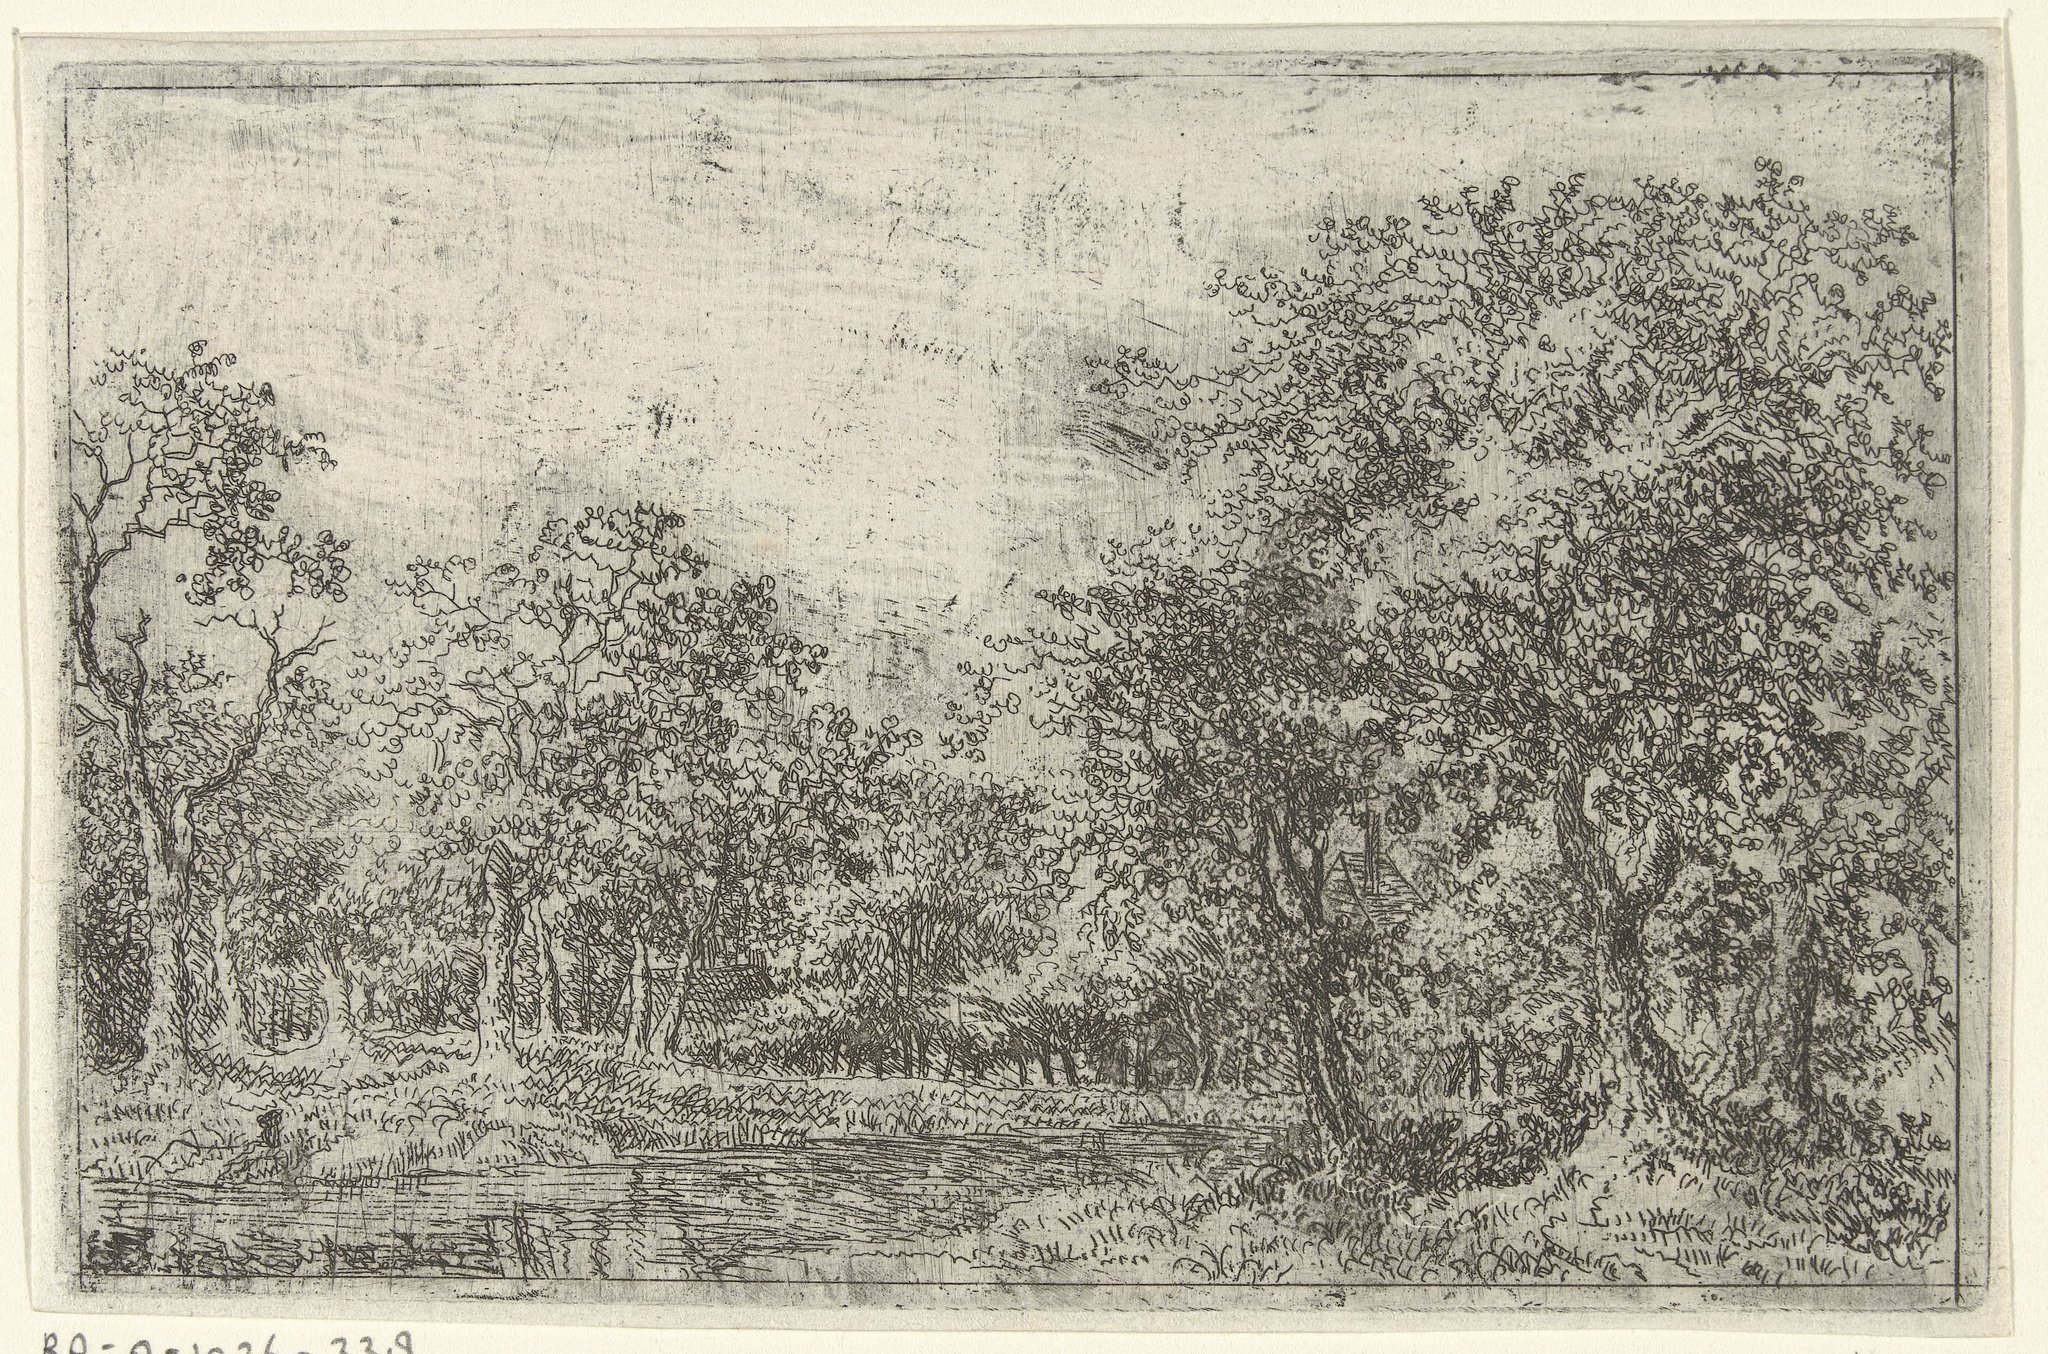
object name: print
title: Landschap met een plas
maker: johan de lagoor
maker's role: draughtsman, painter, print maker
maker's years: 1620-1660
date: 1635-1660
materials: paper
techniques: etching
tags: pool, puddle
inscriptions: collector's mark: Lugt 2228